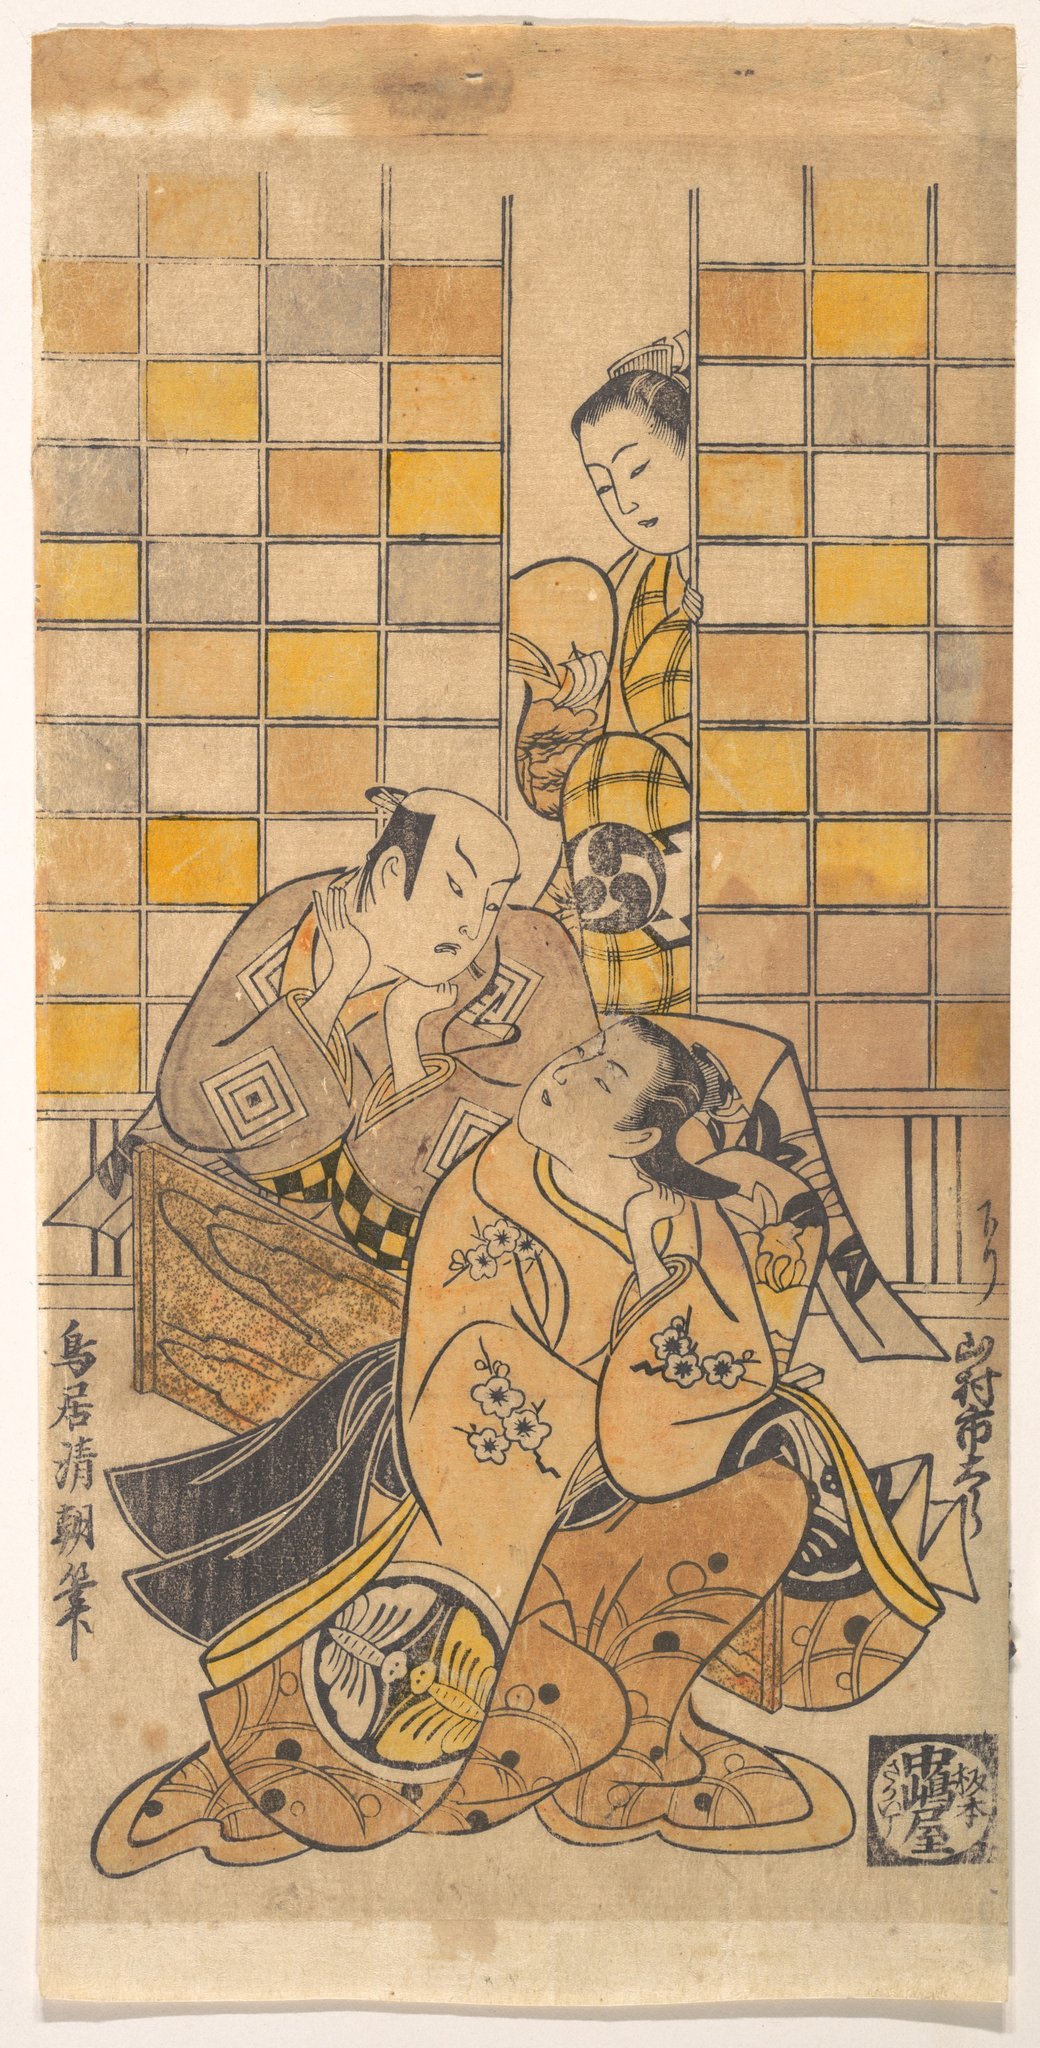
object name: print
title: Ichikawa Danjuro II as Kanto Koroku and Yamamura Ichitaro as Oichi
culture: japanese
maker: torii kiyotomo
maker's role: artist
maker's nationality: japanese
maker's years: 1815-1820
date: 1721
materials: ink, paper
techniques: woodblock print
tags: men,women,actors